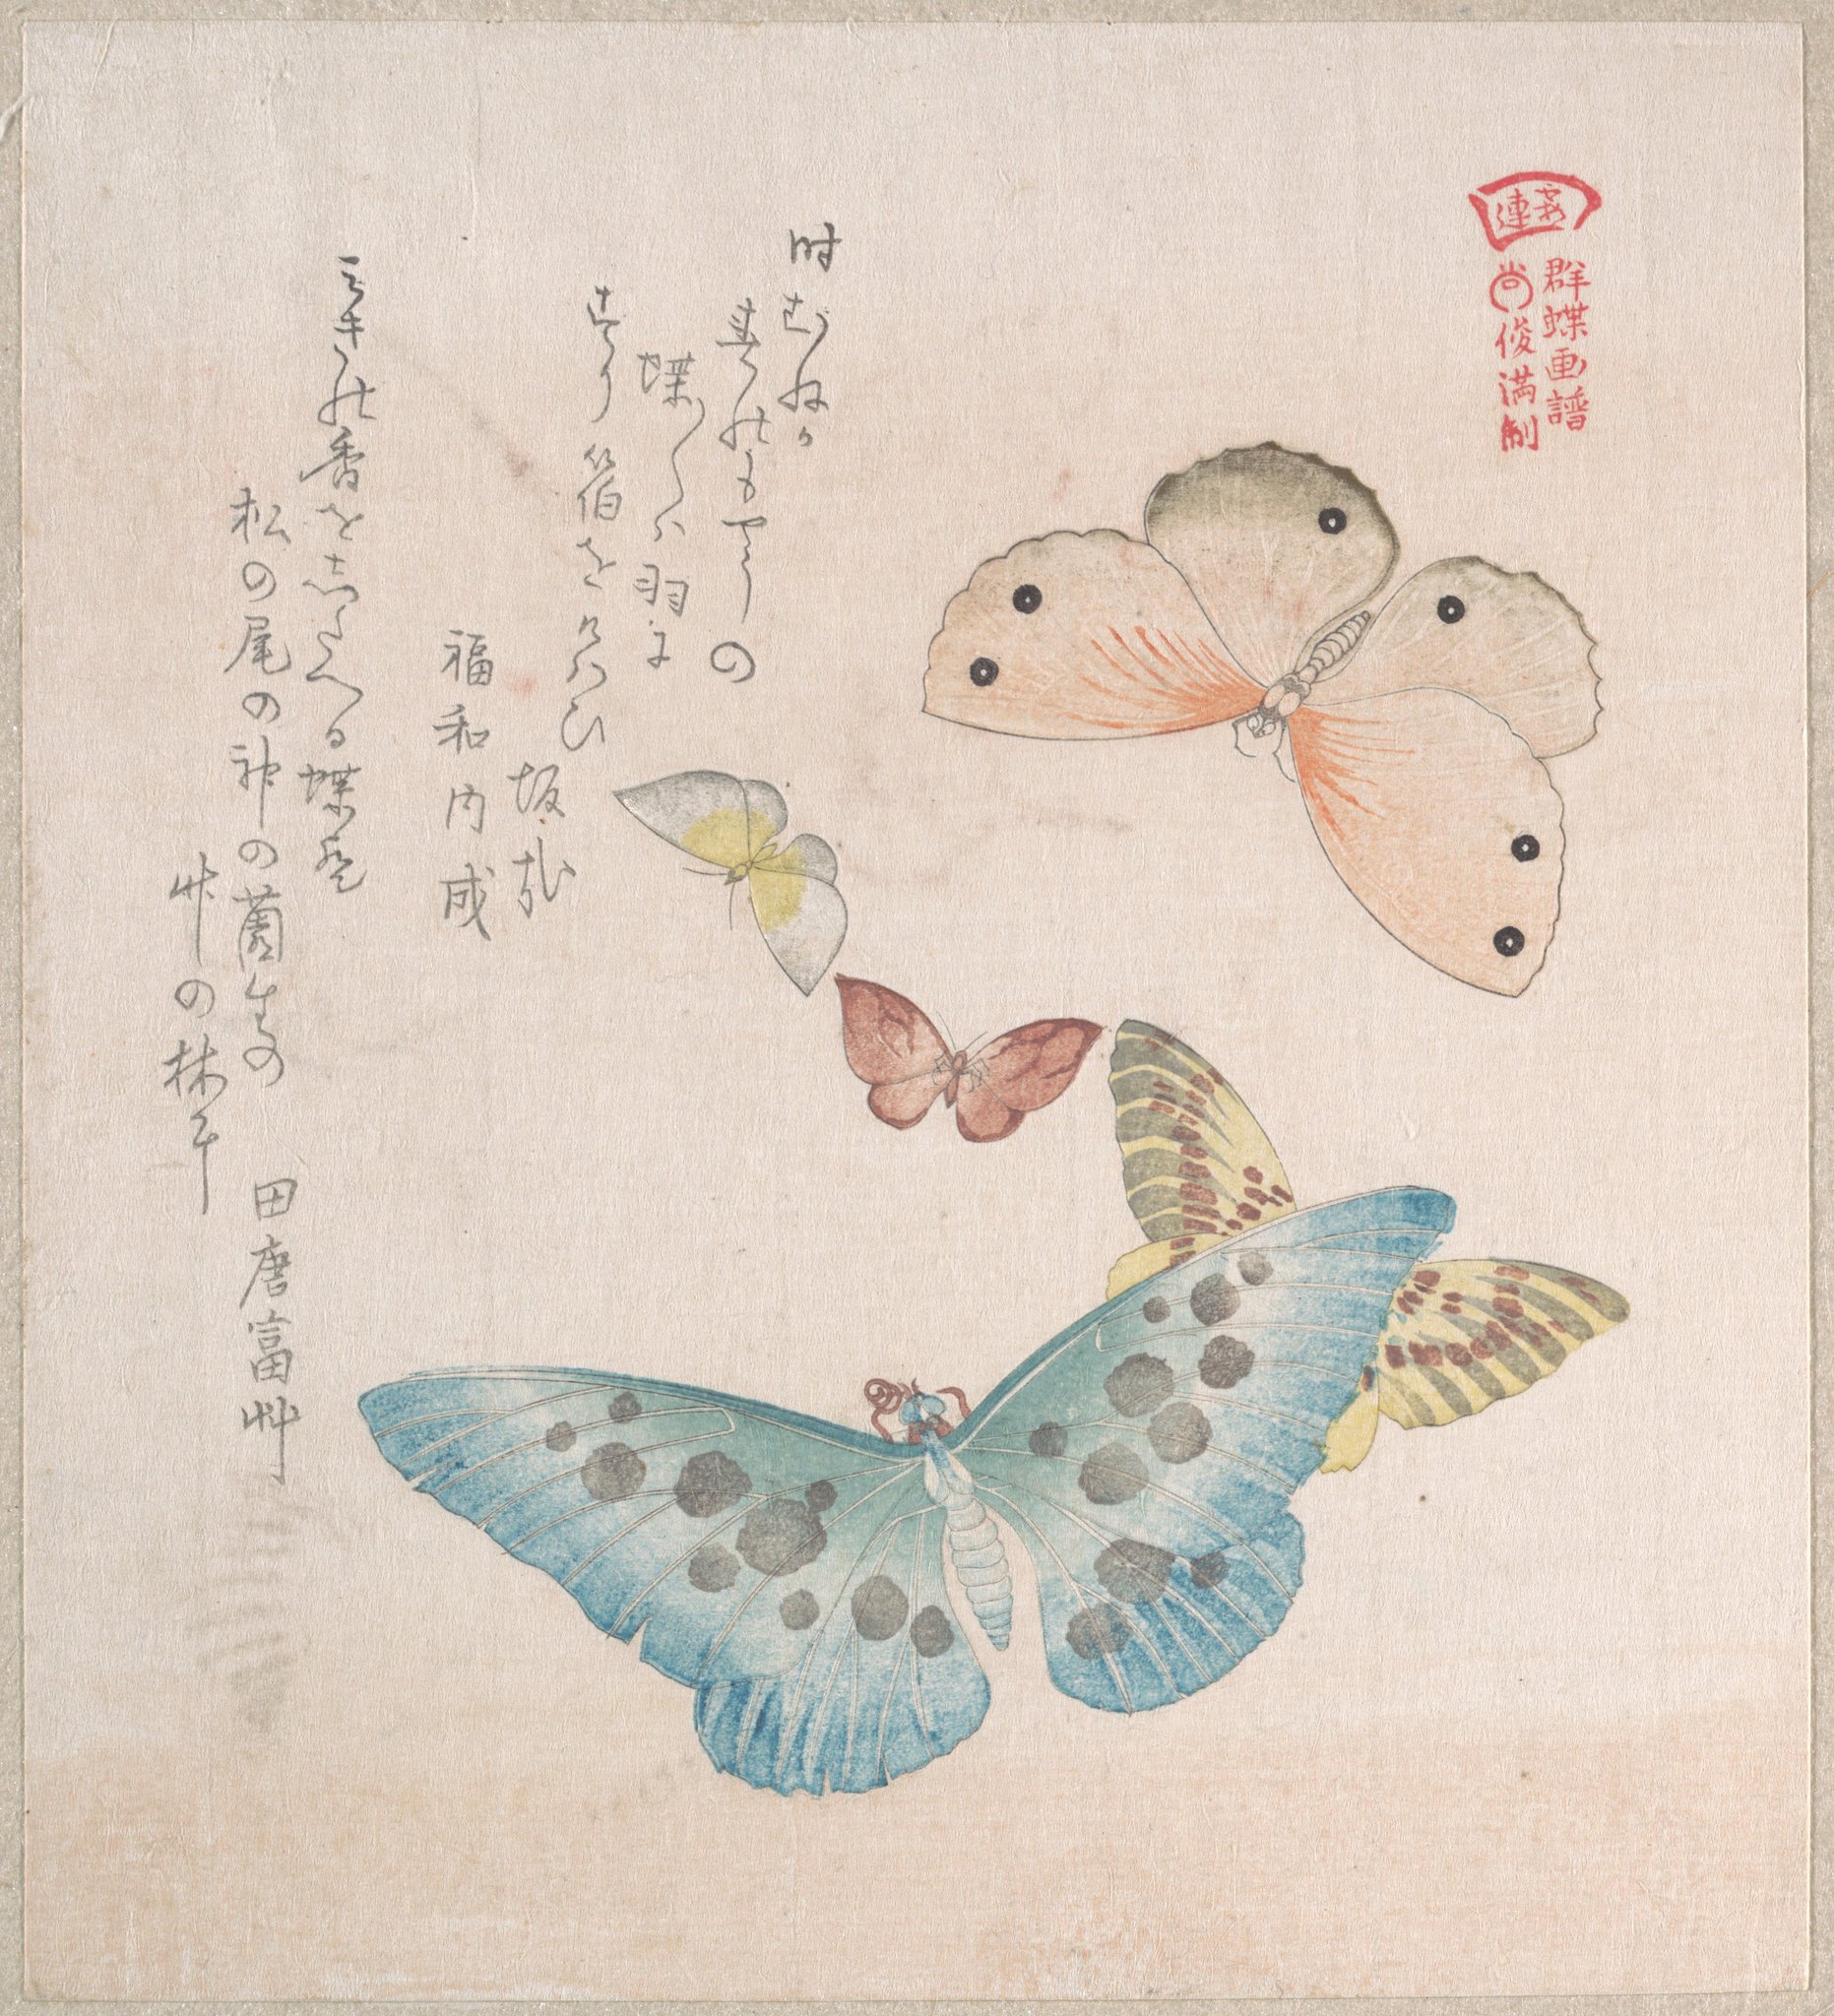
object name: print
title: Various Moths and Butterflies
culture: japanese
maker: kubo shunman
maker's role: artist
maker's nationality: japanese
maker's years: 1757-1820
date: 1801-1900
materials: ink, paper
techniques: surimono, woodblock print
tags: butterflies